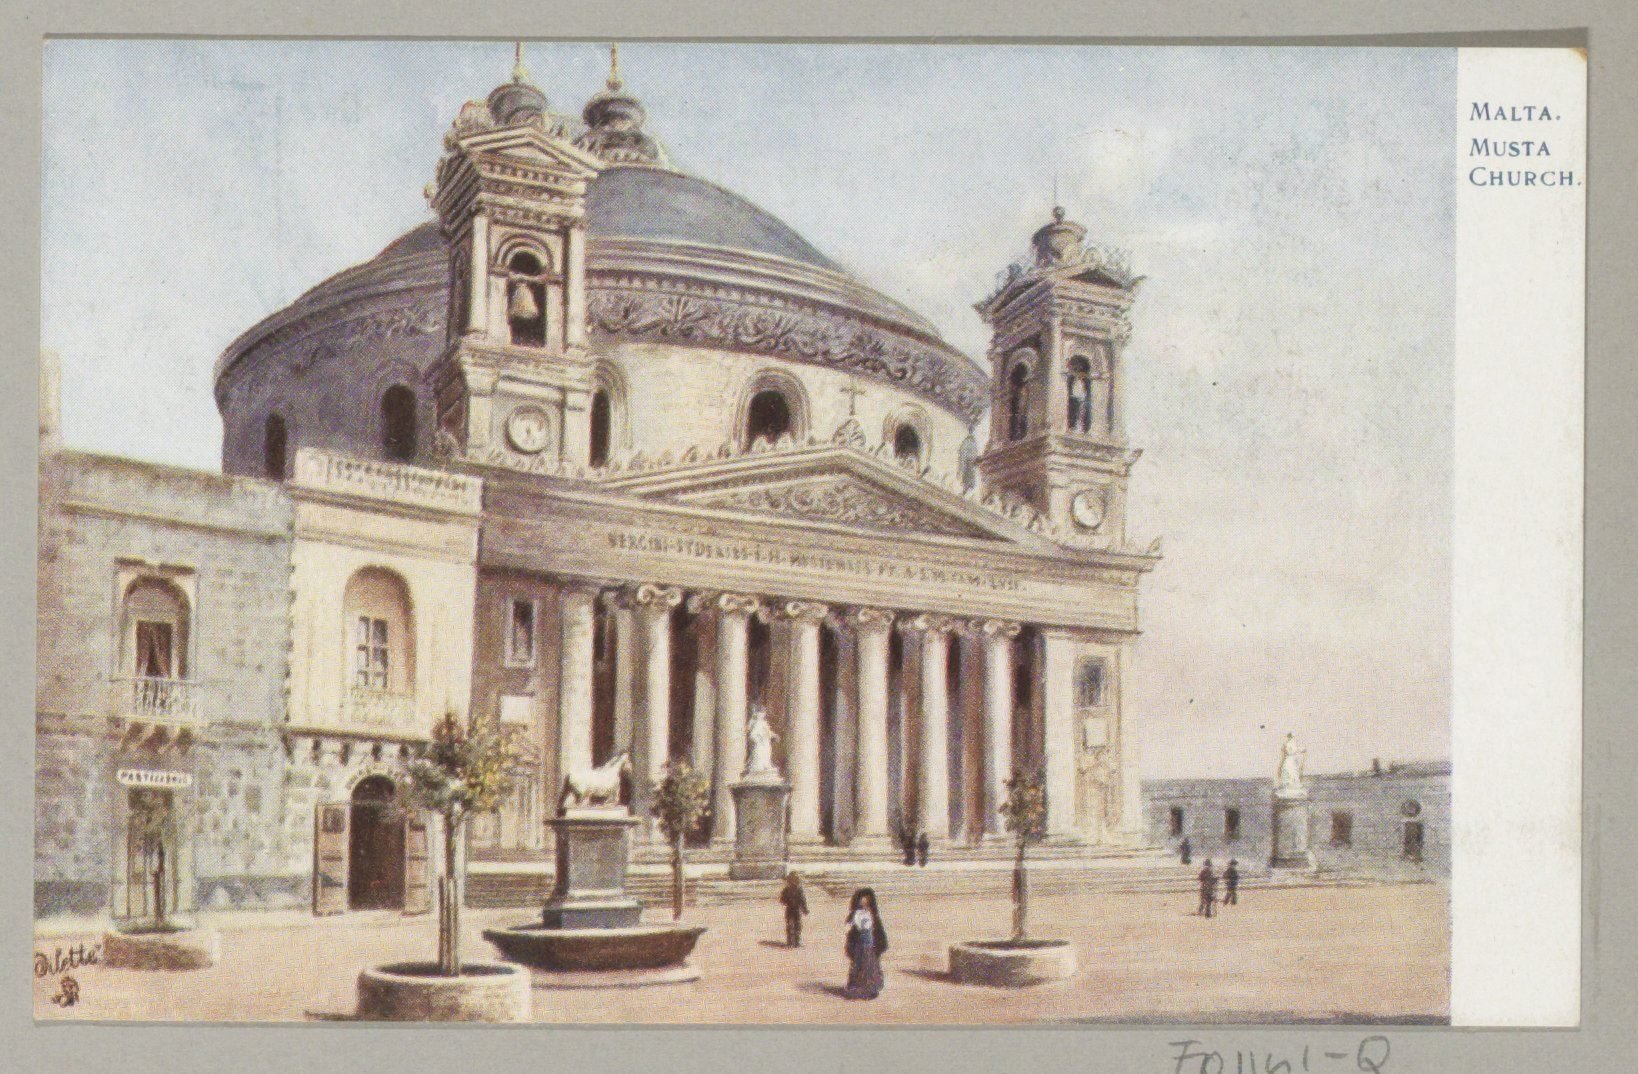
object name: photomechanical print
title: Malta. Musta Church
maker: Anonymous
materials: paper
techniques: color autotype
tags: church (exterior)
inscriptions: name: ‘[...]ilette’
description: Onderdeel van Fotoalbum van een reis door Zuid-Europa en het Midden-Oosten.